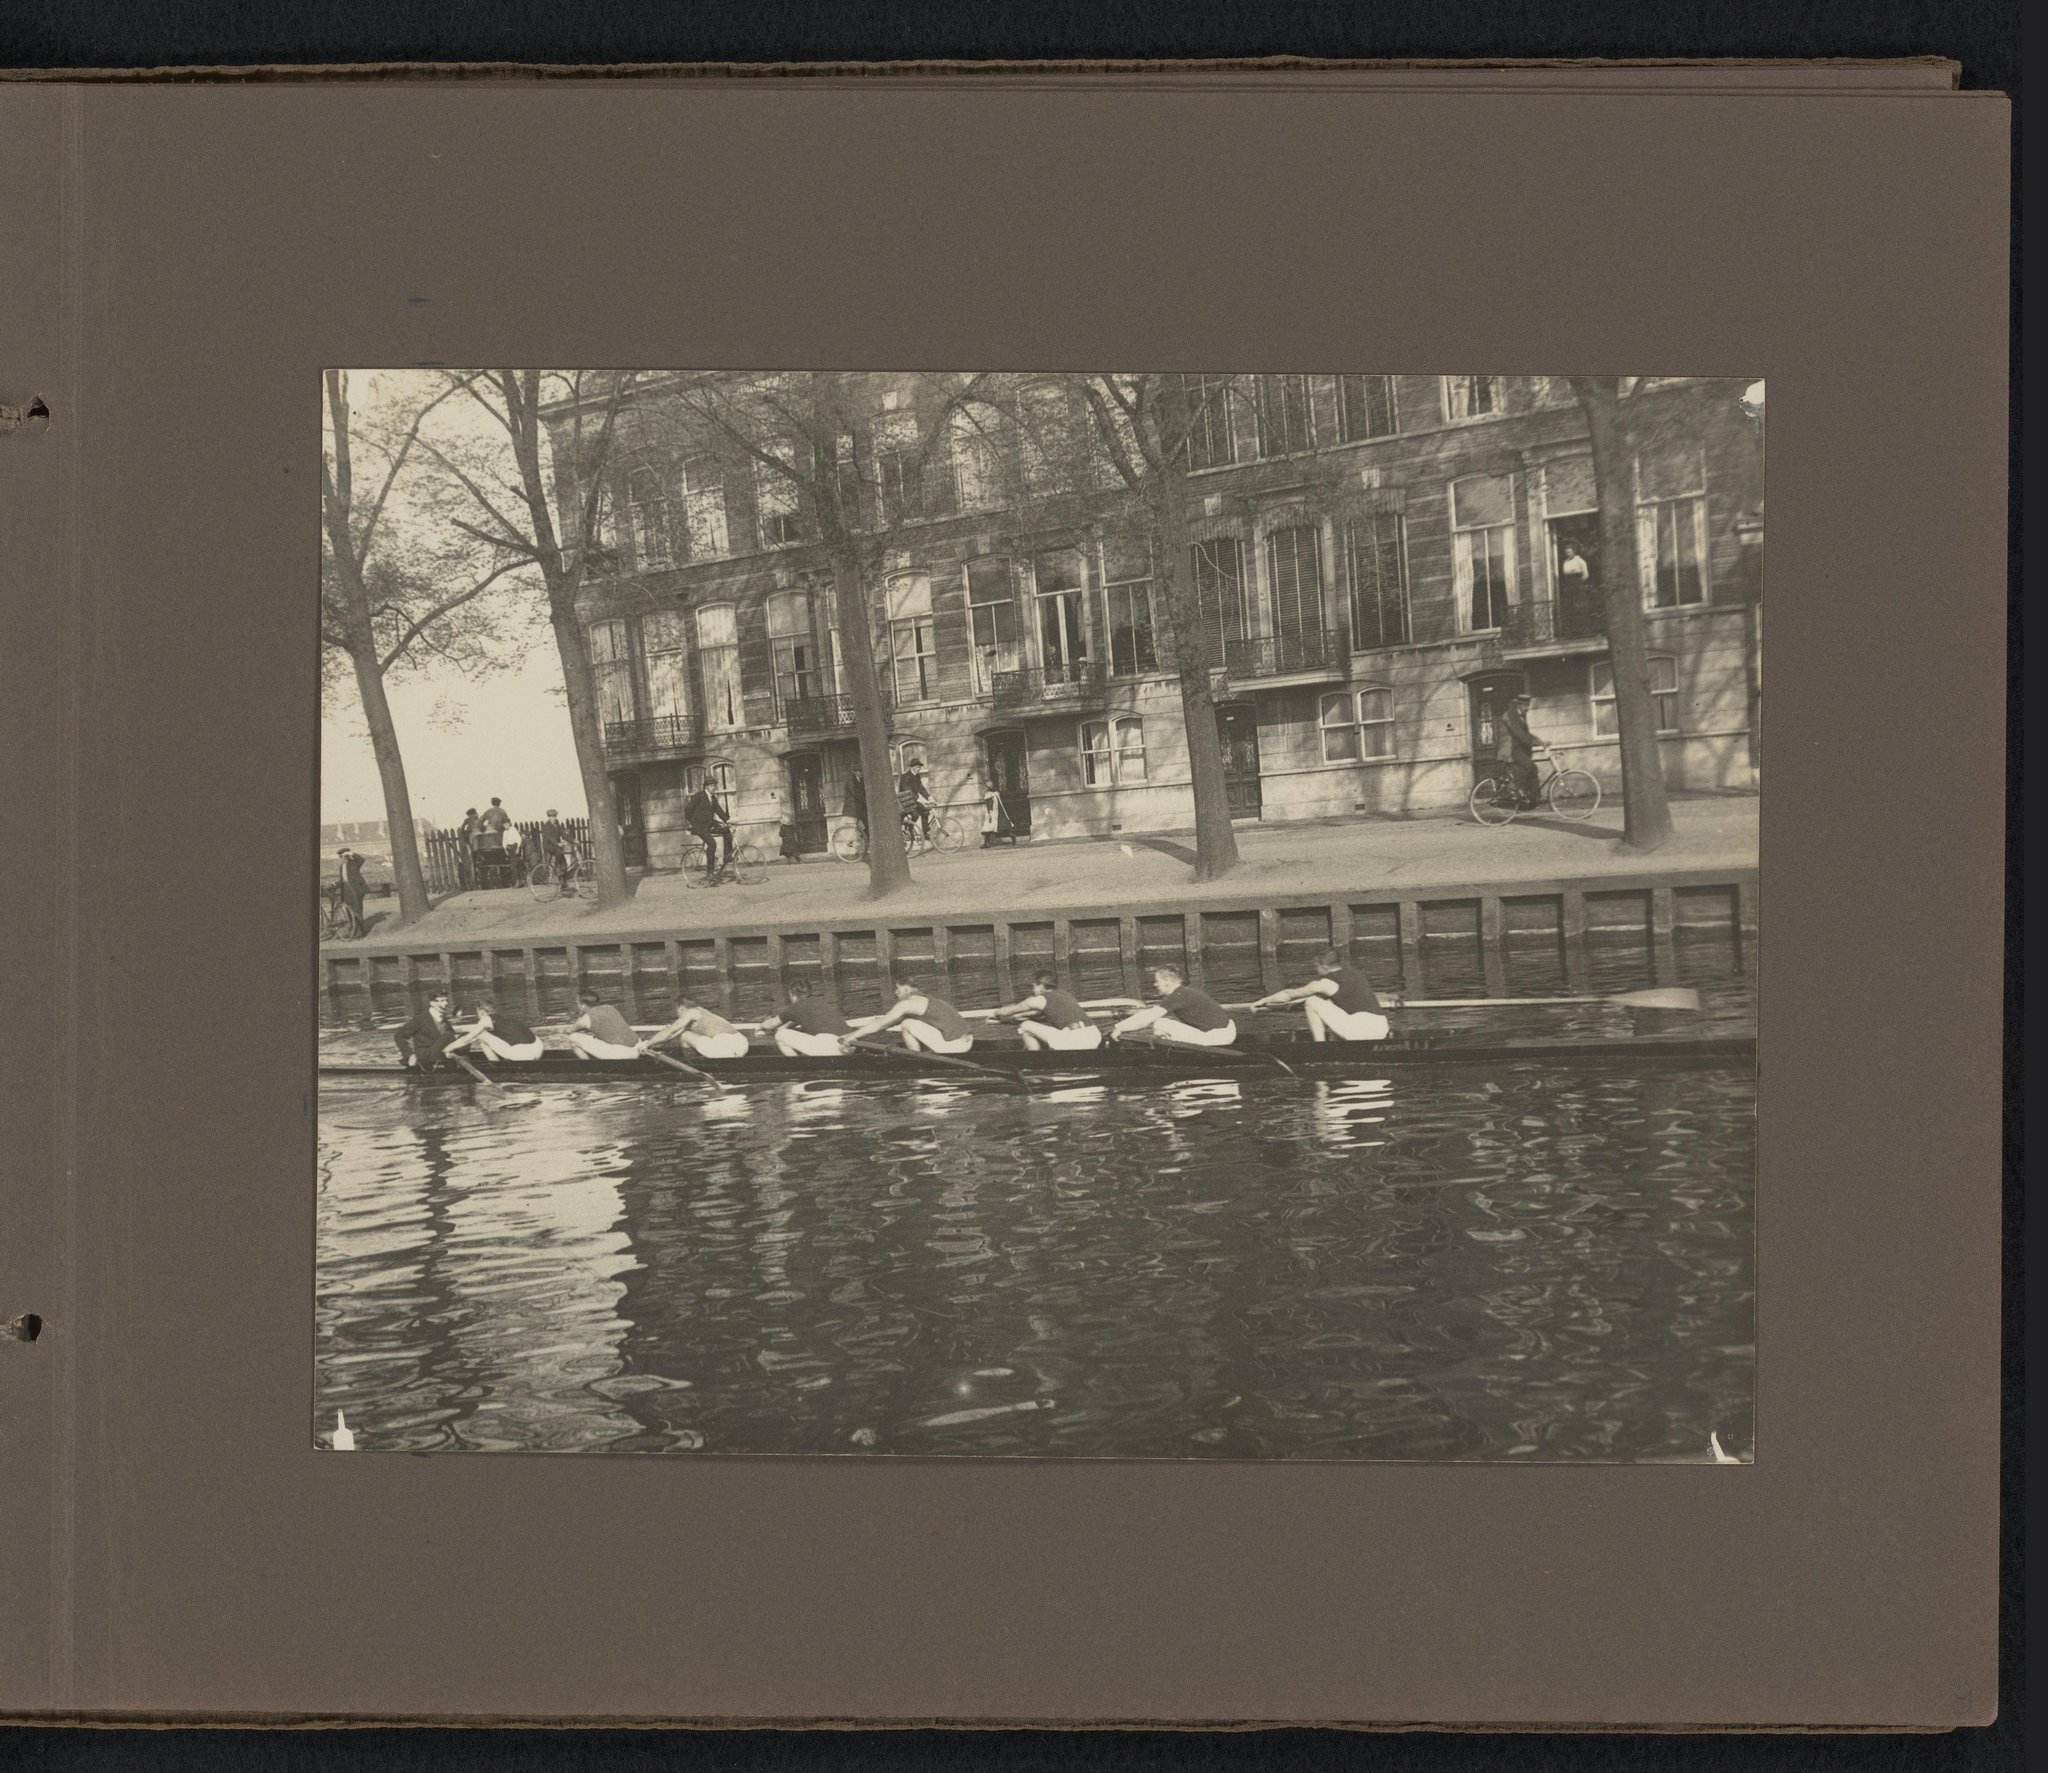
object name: photograph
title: Roeiploeg Jonge Acht in actie te Delft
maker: Anonymous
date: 1915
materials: paper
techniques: gelatin silver print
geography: delft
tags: rowing facing backward, pulling, delft